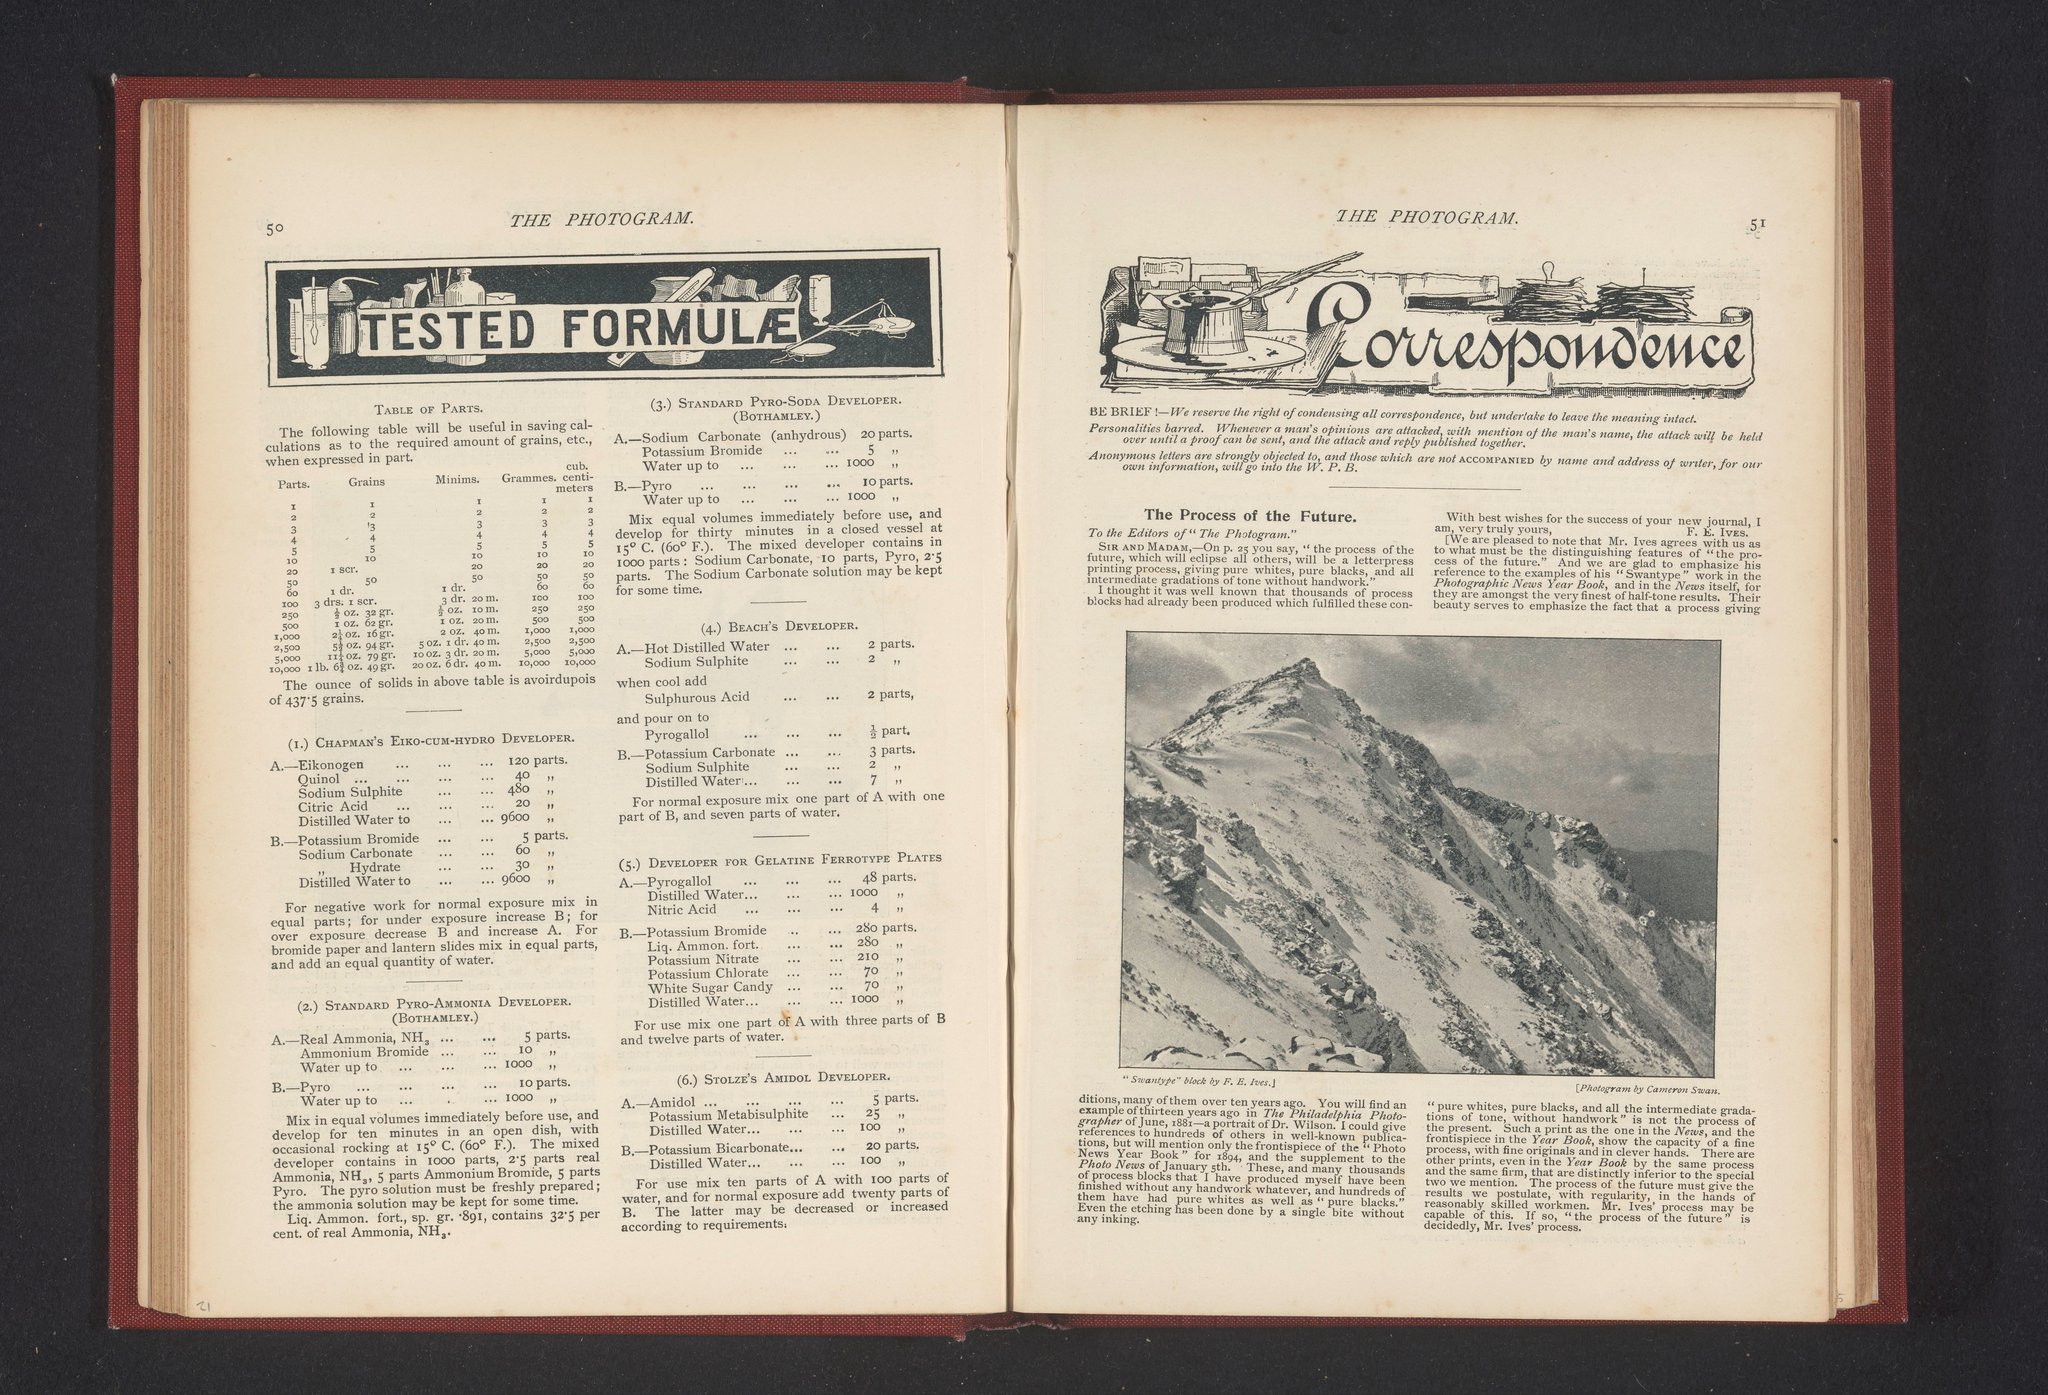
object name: page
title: Besneeuwde bergtop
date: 1889-1894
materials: paper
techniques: autotype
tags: mountain-top, peak, snow